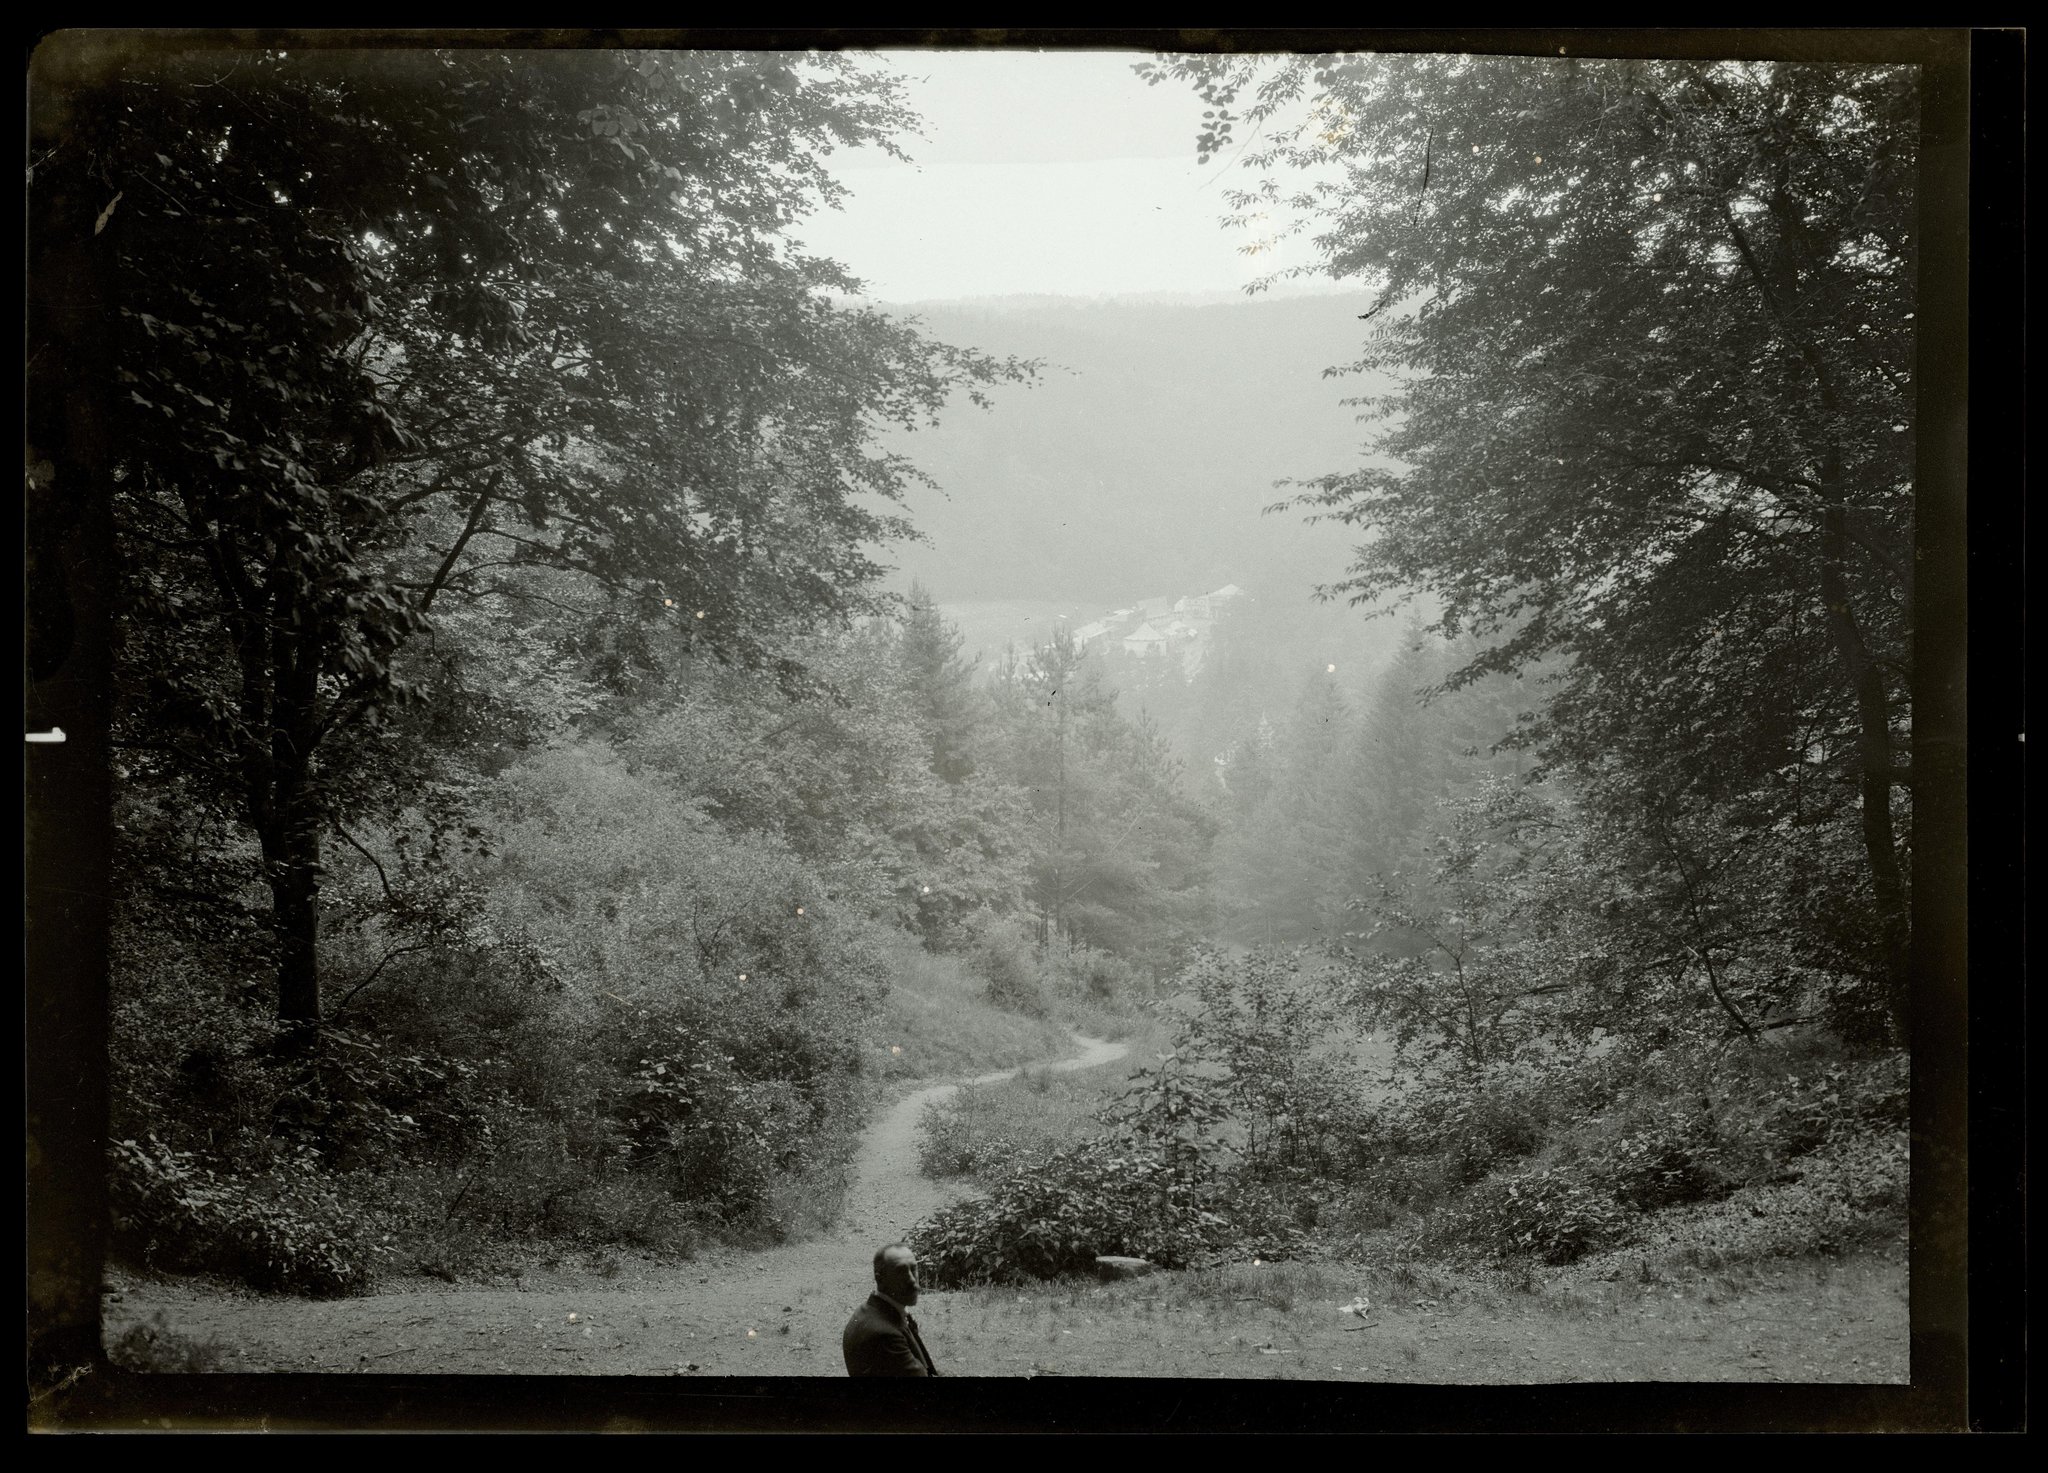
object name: photograph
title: Filmnegatief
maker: Anonymous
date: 1907-1935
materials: film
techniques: gelatin silver negative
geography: europe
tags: europe